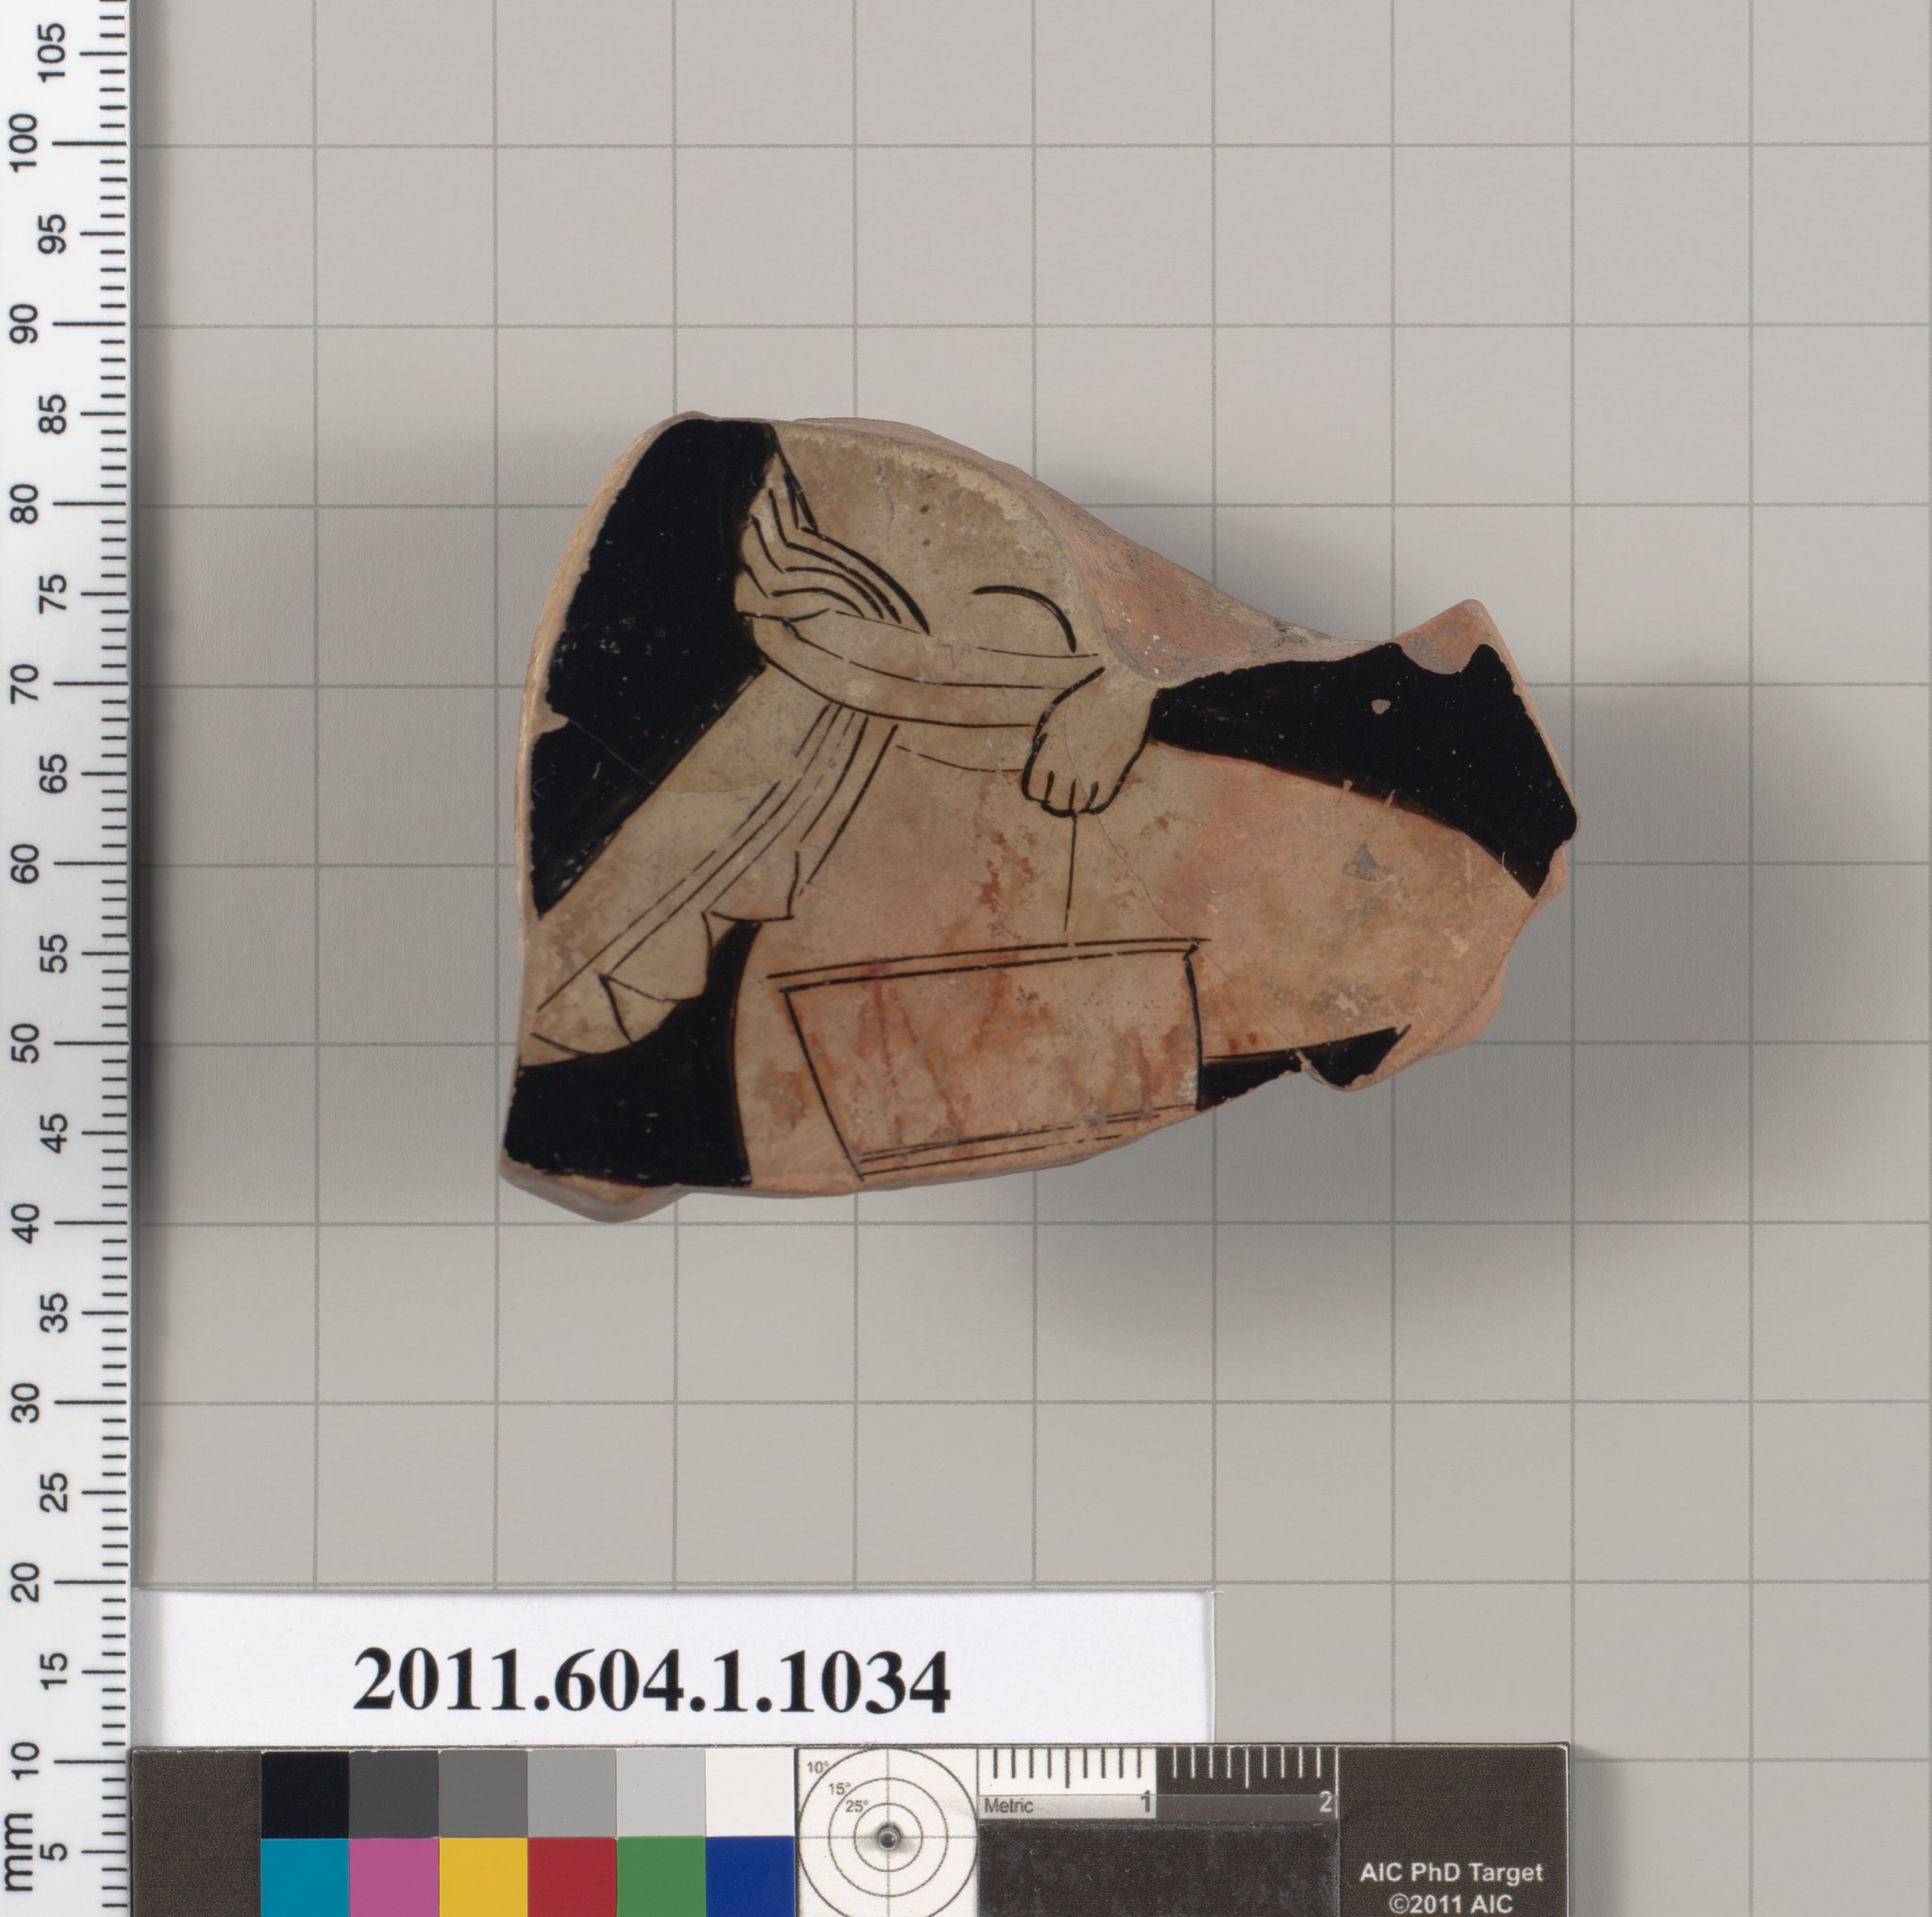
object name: kylix fragment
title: Terracotta fragment of a kylix (drinking cup)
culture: greek, attic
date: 490-480 BCE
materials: terracotta